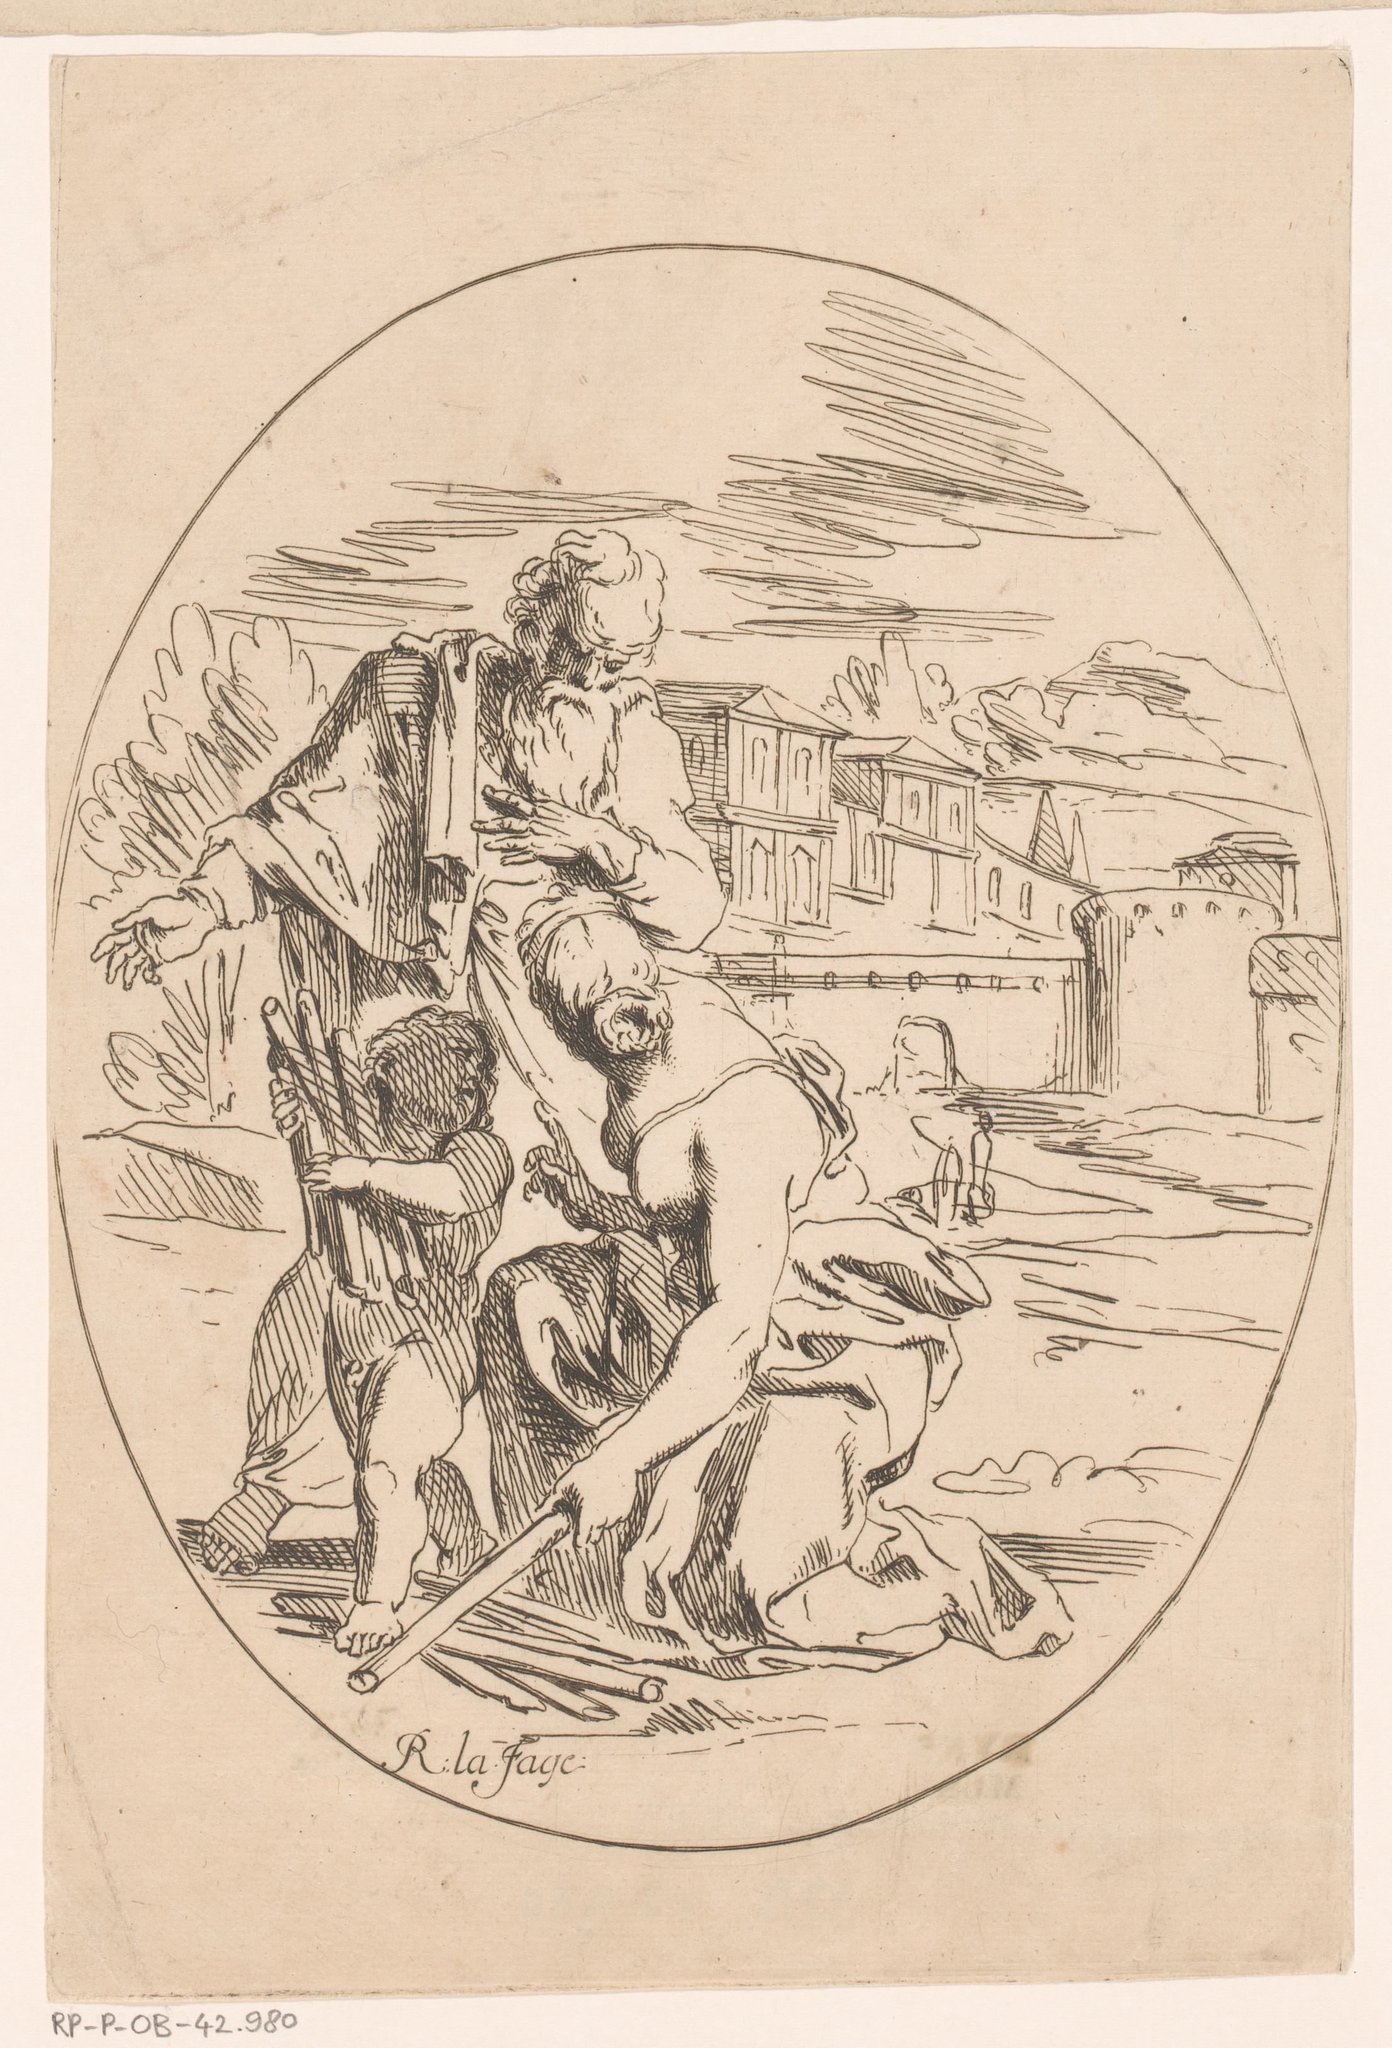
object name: print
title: Staande oude man bij geknielde vrouw en kind dat stokken draagt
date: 1708-1779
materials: paper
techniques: etching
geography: france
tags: woodgathering, woodgatherer, old man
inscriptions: collector's mark: Lugt 2165